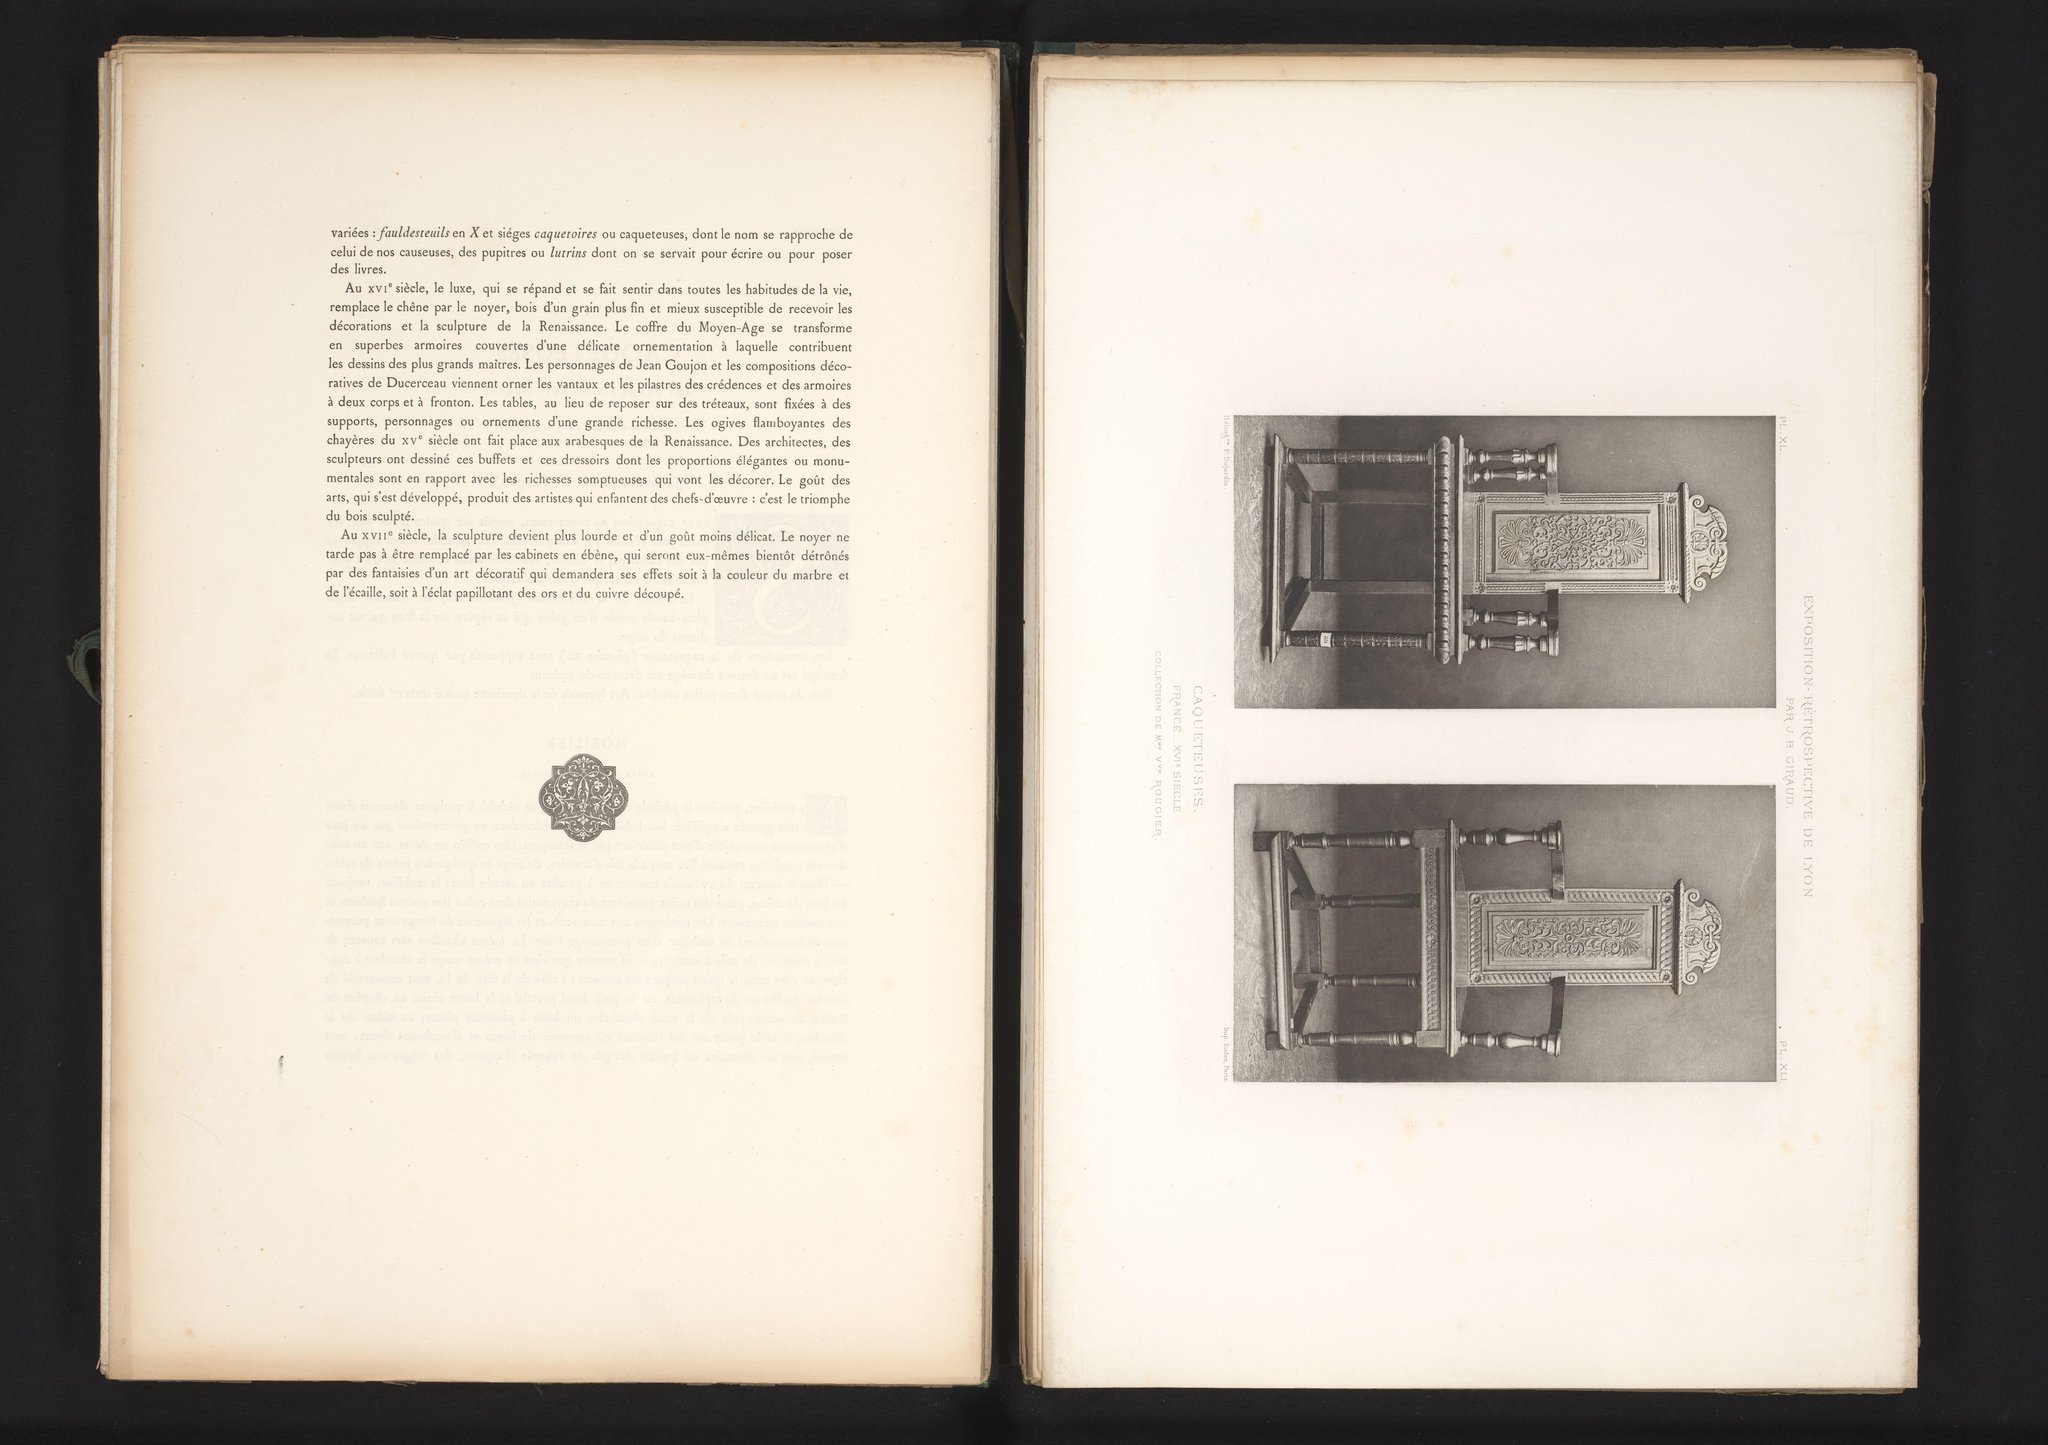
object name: photomechanical print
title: Twee 16de-eeuwse Franse stoelen van hout, op de Exposition Rétrospective van 1877 in Lyon, Frankrijk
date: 1877-1878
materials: paper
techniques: photoaquatint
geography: paris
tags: chair (+ wood and other phytogenic material), lyon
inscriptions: number: ‘PL. XL.’, inscription: ‘EXPOSITION RÉTROSPECTIVE DE LYON/ PAR J. B. GIRAUD.’, number: ‘PL. XLI.’, inscription: ‘CAQUETEUSES/ FRANCE_XVIe SIÈCLE/ COLLECTION DE Mme Vve ROUGIER.’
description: Deze prenten maken deel uit van een omslag met 79 prenten op 54 bladen en 65 tekstbladen.